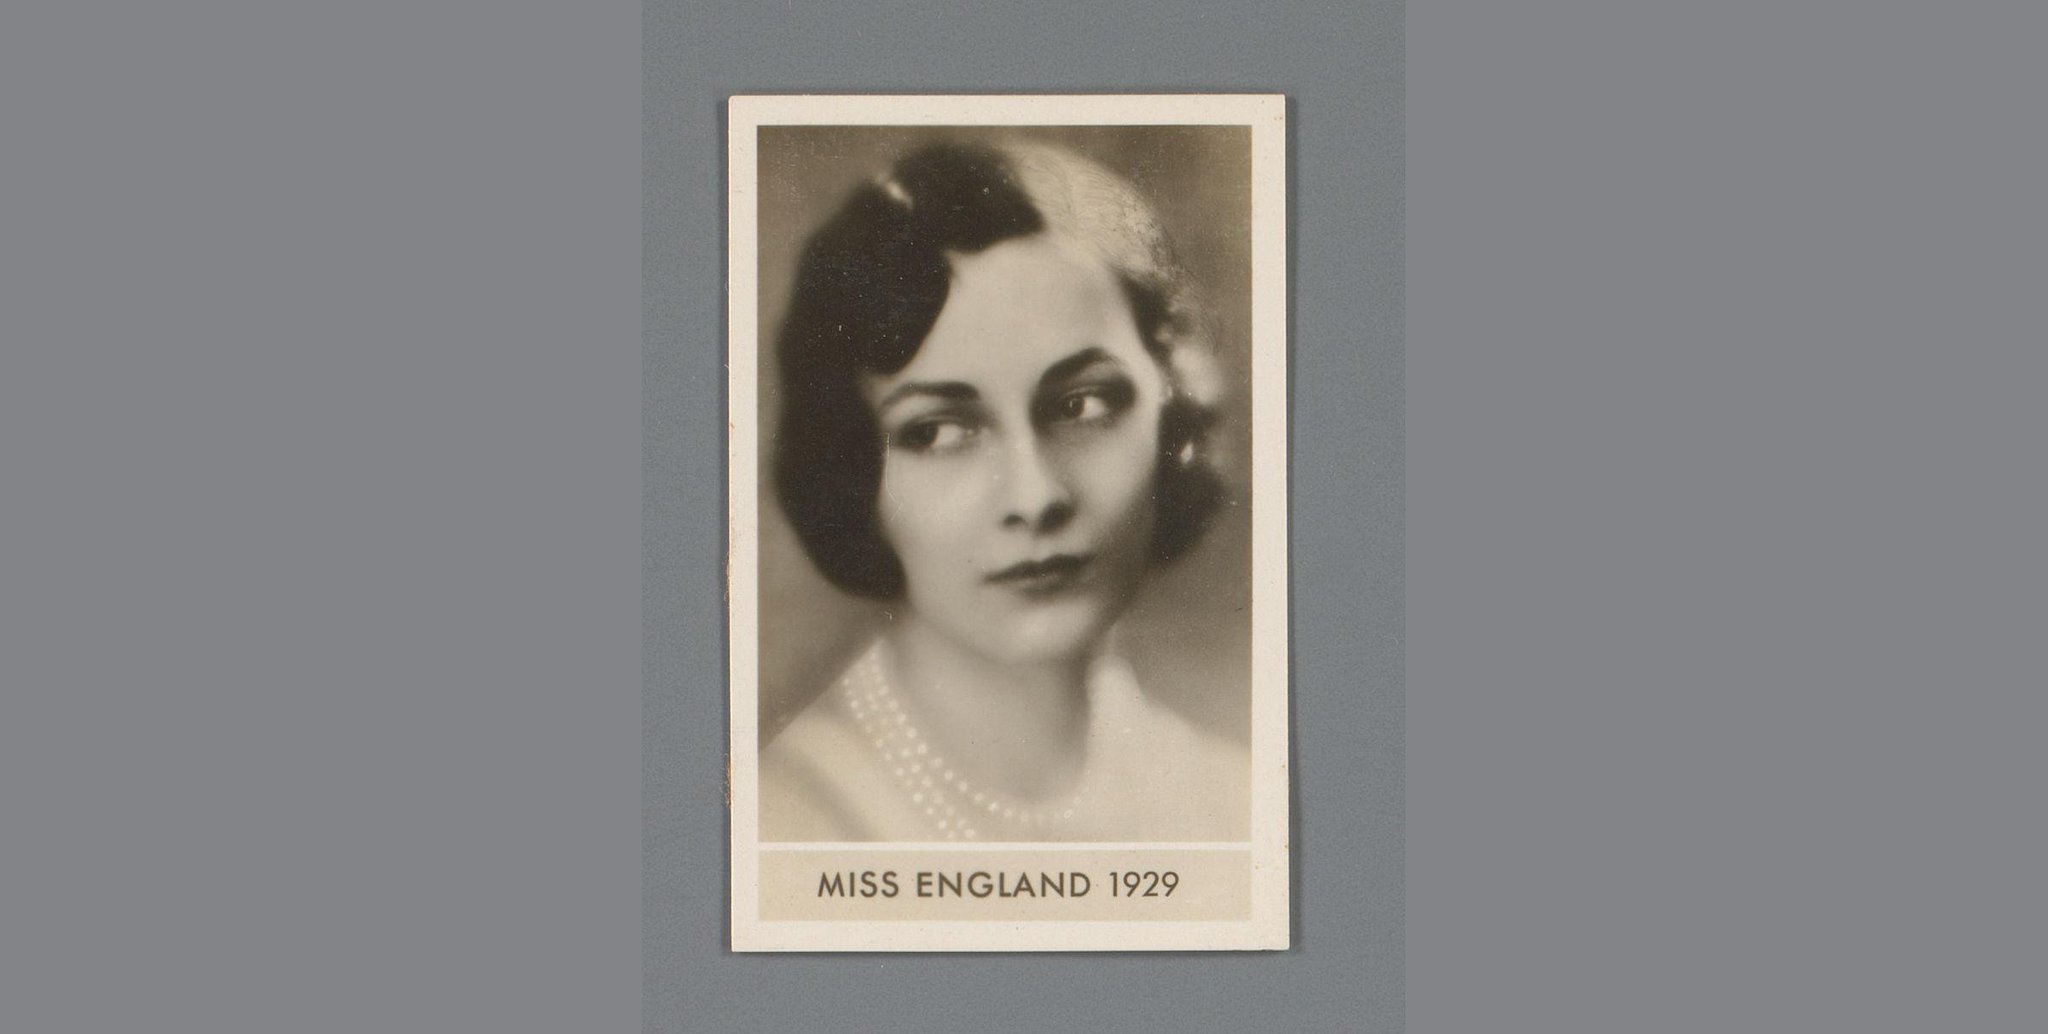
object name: photograph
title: Portret van Benny Dick, Miss Engeland 1929, reclame voor Club & Liga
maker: Anonymous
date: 1929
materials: paper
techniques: gelatin silver print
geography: dresden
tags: historical persons - bb - woman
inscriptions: inscription: ‘Die schönsten/ Frauen der Welt/ dargestellt durch die Schön-/ heitsköniginnen aller Länder,/ finden Sie in 190 echten/ Bromsilber-Fotos, die nur den/ CLUB-und-LIGA-Packun-/ gen beiliegen. Eind prächtiges/ Sammel-Album erhalten Sie/ für 75 Pfennig vom Händler/ oder bei Einsendung von/ 75 Pfennig in Briefmarken/ von der Bilderstelle Lohse,/ Dresden A24, Nossener Str. 1./ Ges. gesch. Nachdruck verboten!’